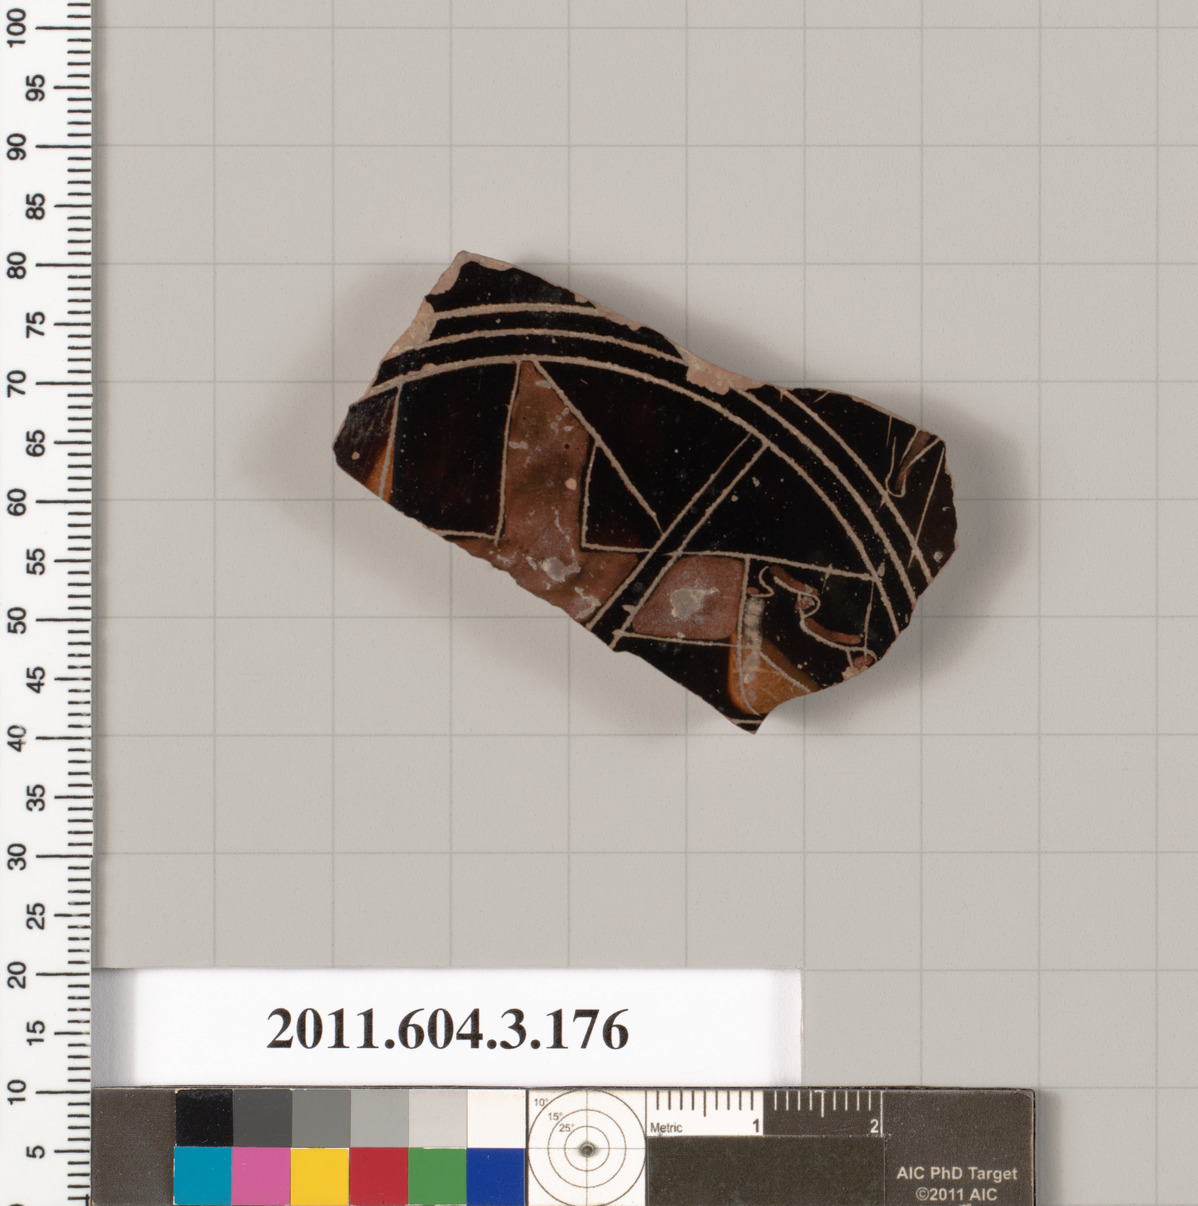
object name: amphora fragment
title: Terracotta fragment of an amphora (jar)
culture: greek, attic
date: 550-526 BCE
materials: terracotta